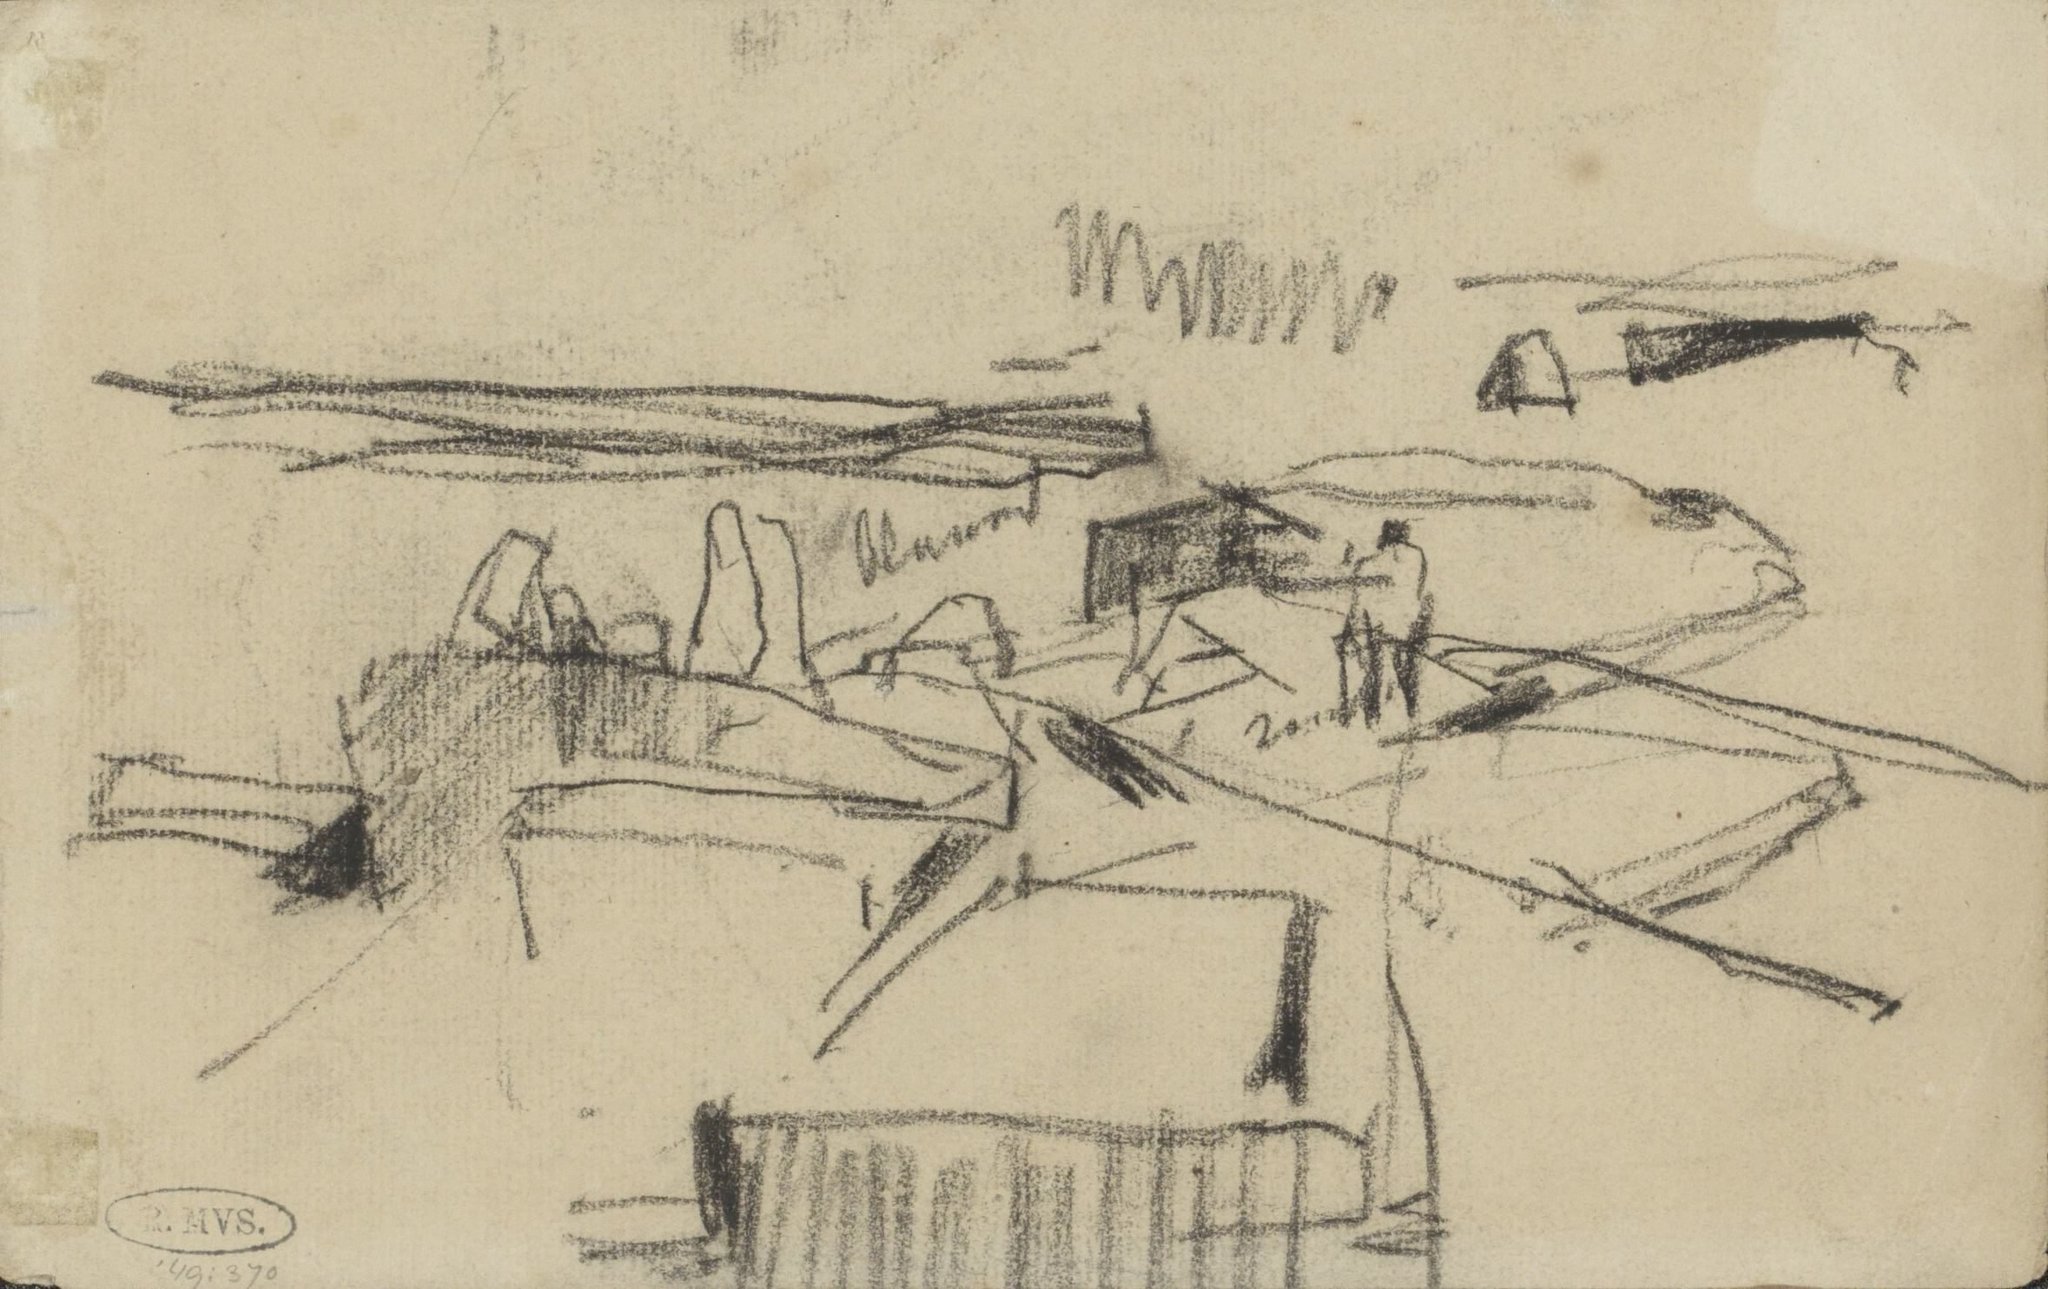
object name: drawing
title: Landschap, mogelijk met bunkers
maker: george hendrik breitner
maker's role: draughtsman, painter, print maker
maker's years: 1857-1923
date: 1895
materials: chalk, paper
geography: the hague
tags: underground shelters, landscapes in the temperate zone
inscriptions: collector's mark: Lugt 2228